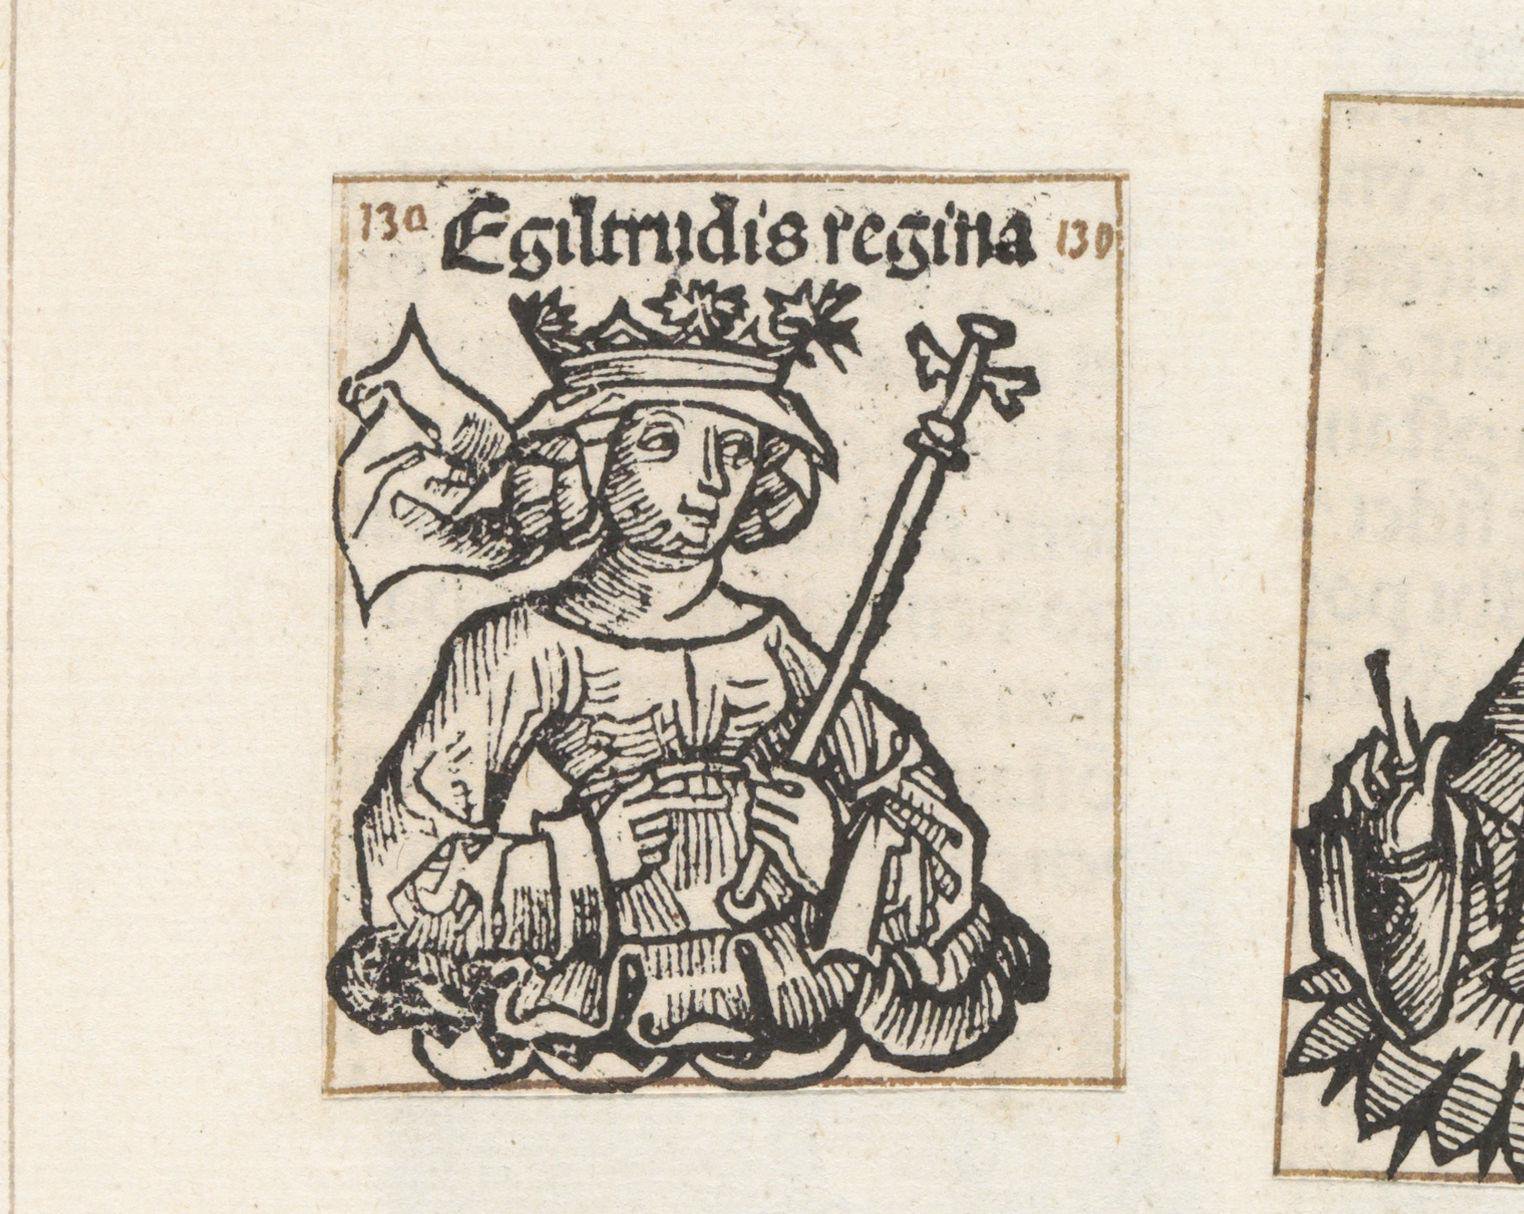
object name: book illustration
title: Heilige Ethelreda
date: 1493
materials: paper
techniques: letterpress printing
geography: nuremberg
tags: queen, empress, etc. (wife of a ruler), female saints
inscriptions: inscription: ‘130’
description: De houtsnede wordt herhaaldelijk gebruikt als boekillustratie in de Liber Chronicarum (of Neurenbergkroniek) van Hartmann Schedel, verschenen in het Latijn en Duits in 1493. Zie de Latijnse uitgave, folio 154v.